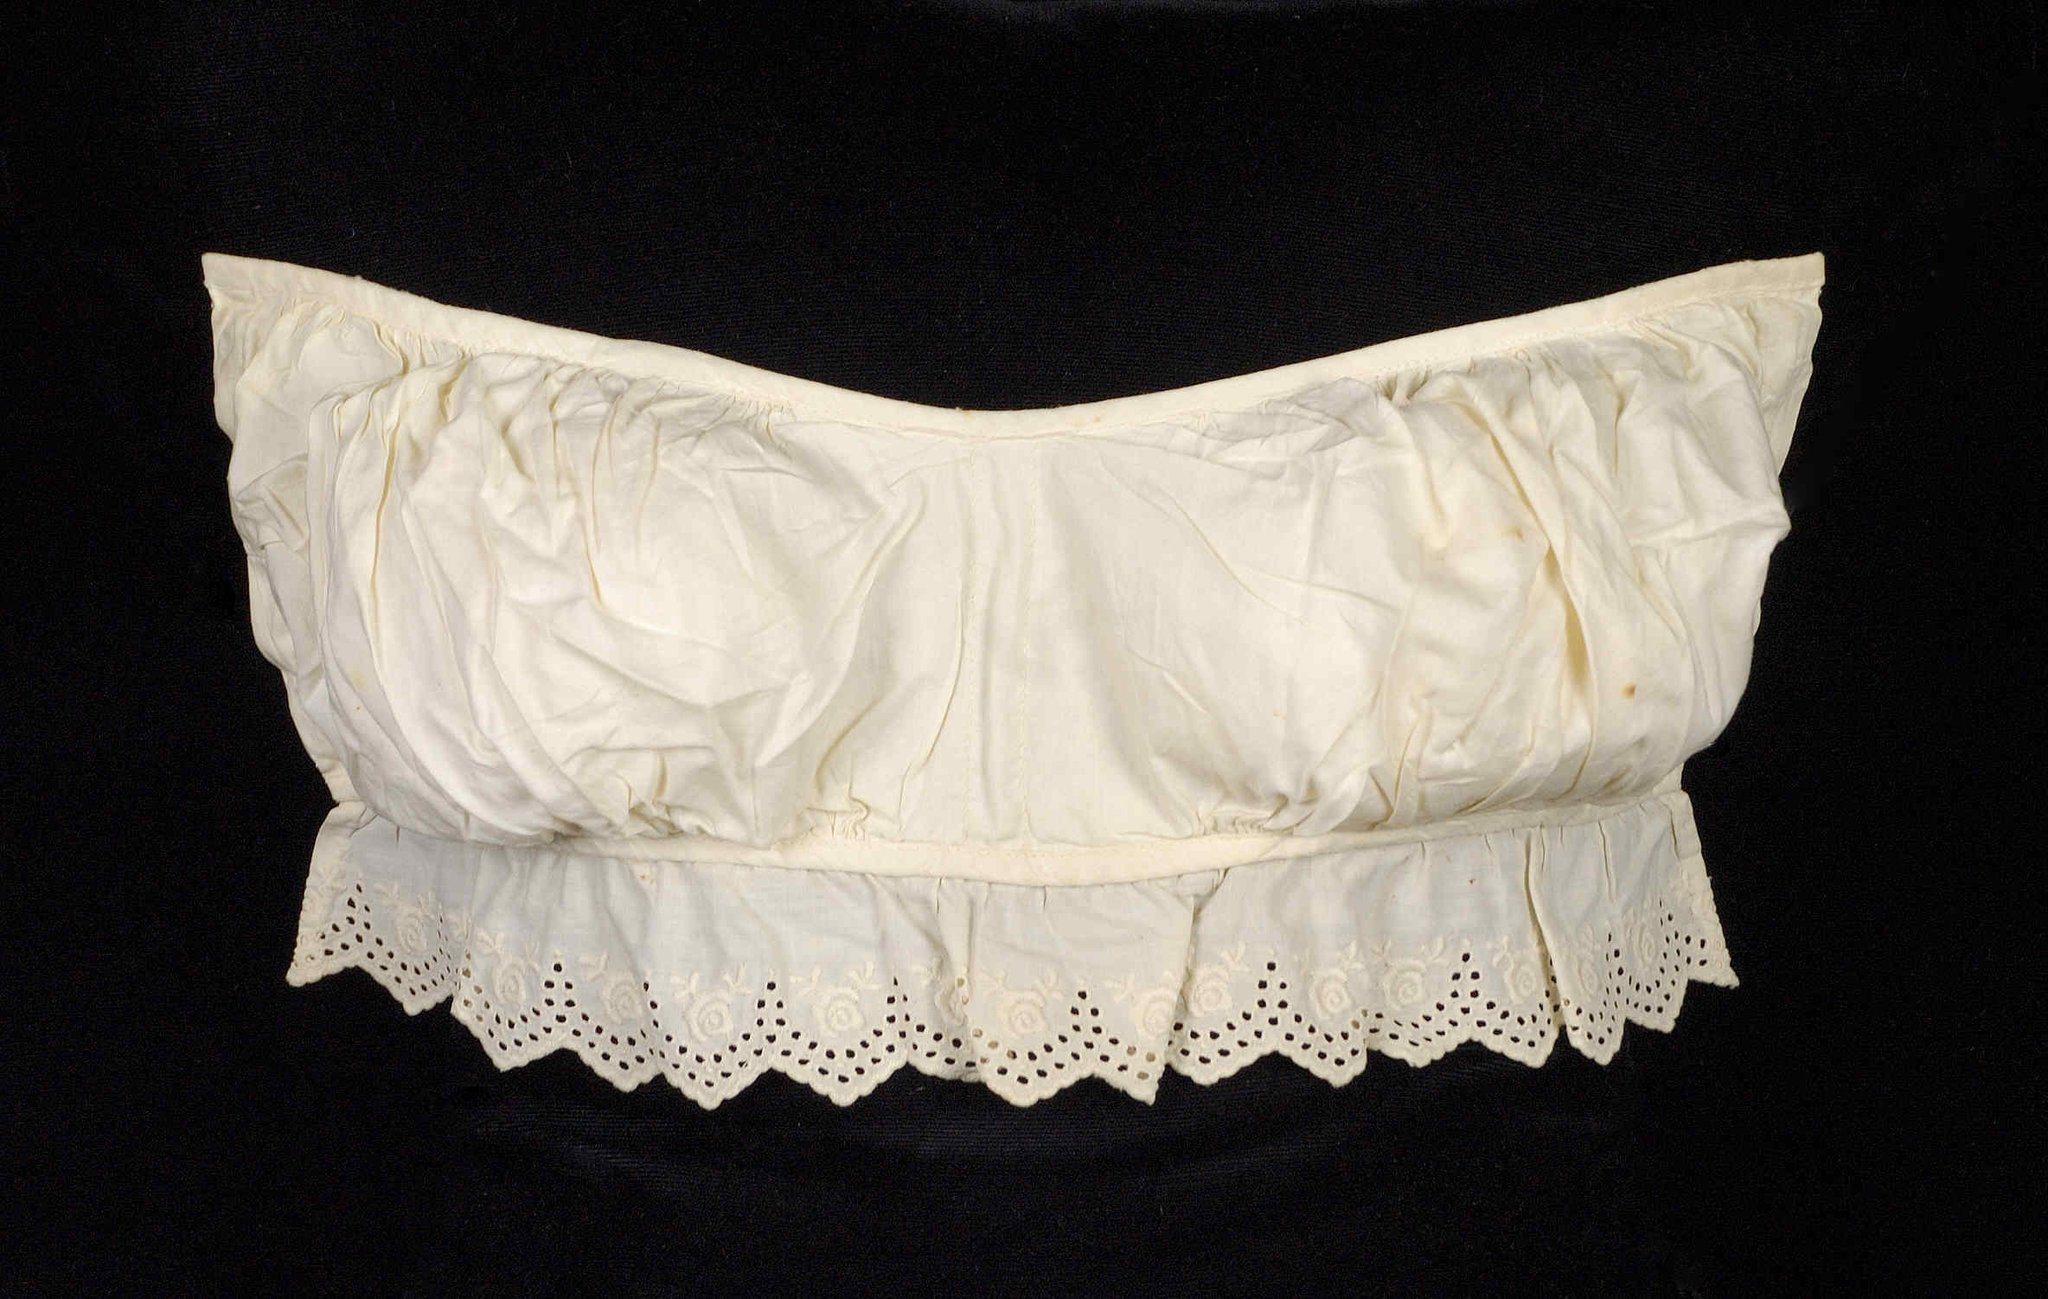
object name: bust form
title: Bust forms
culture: american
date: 1860-1875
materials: cotton